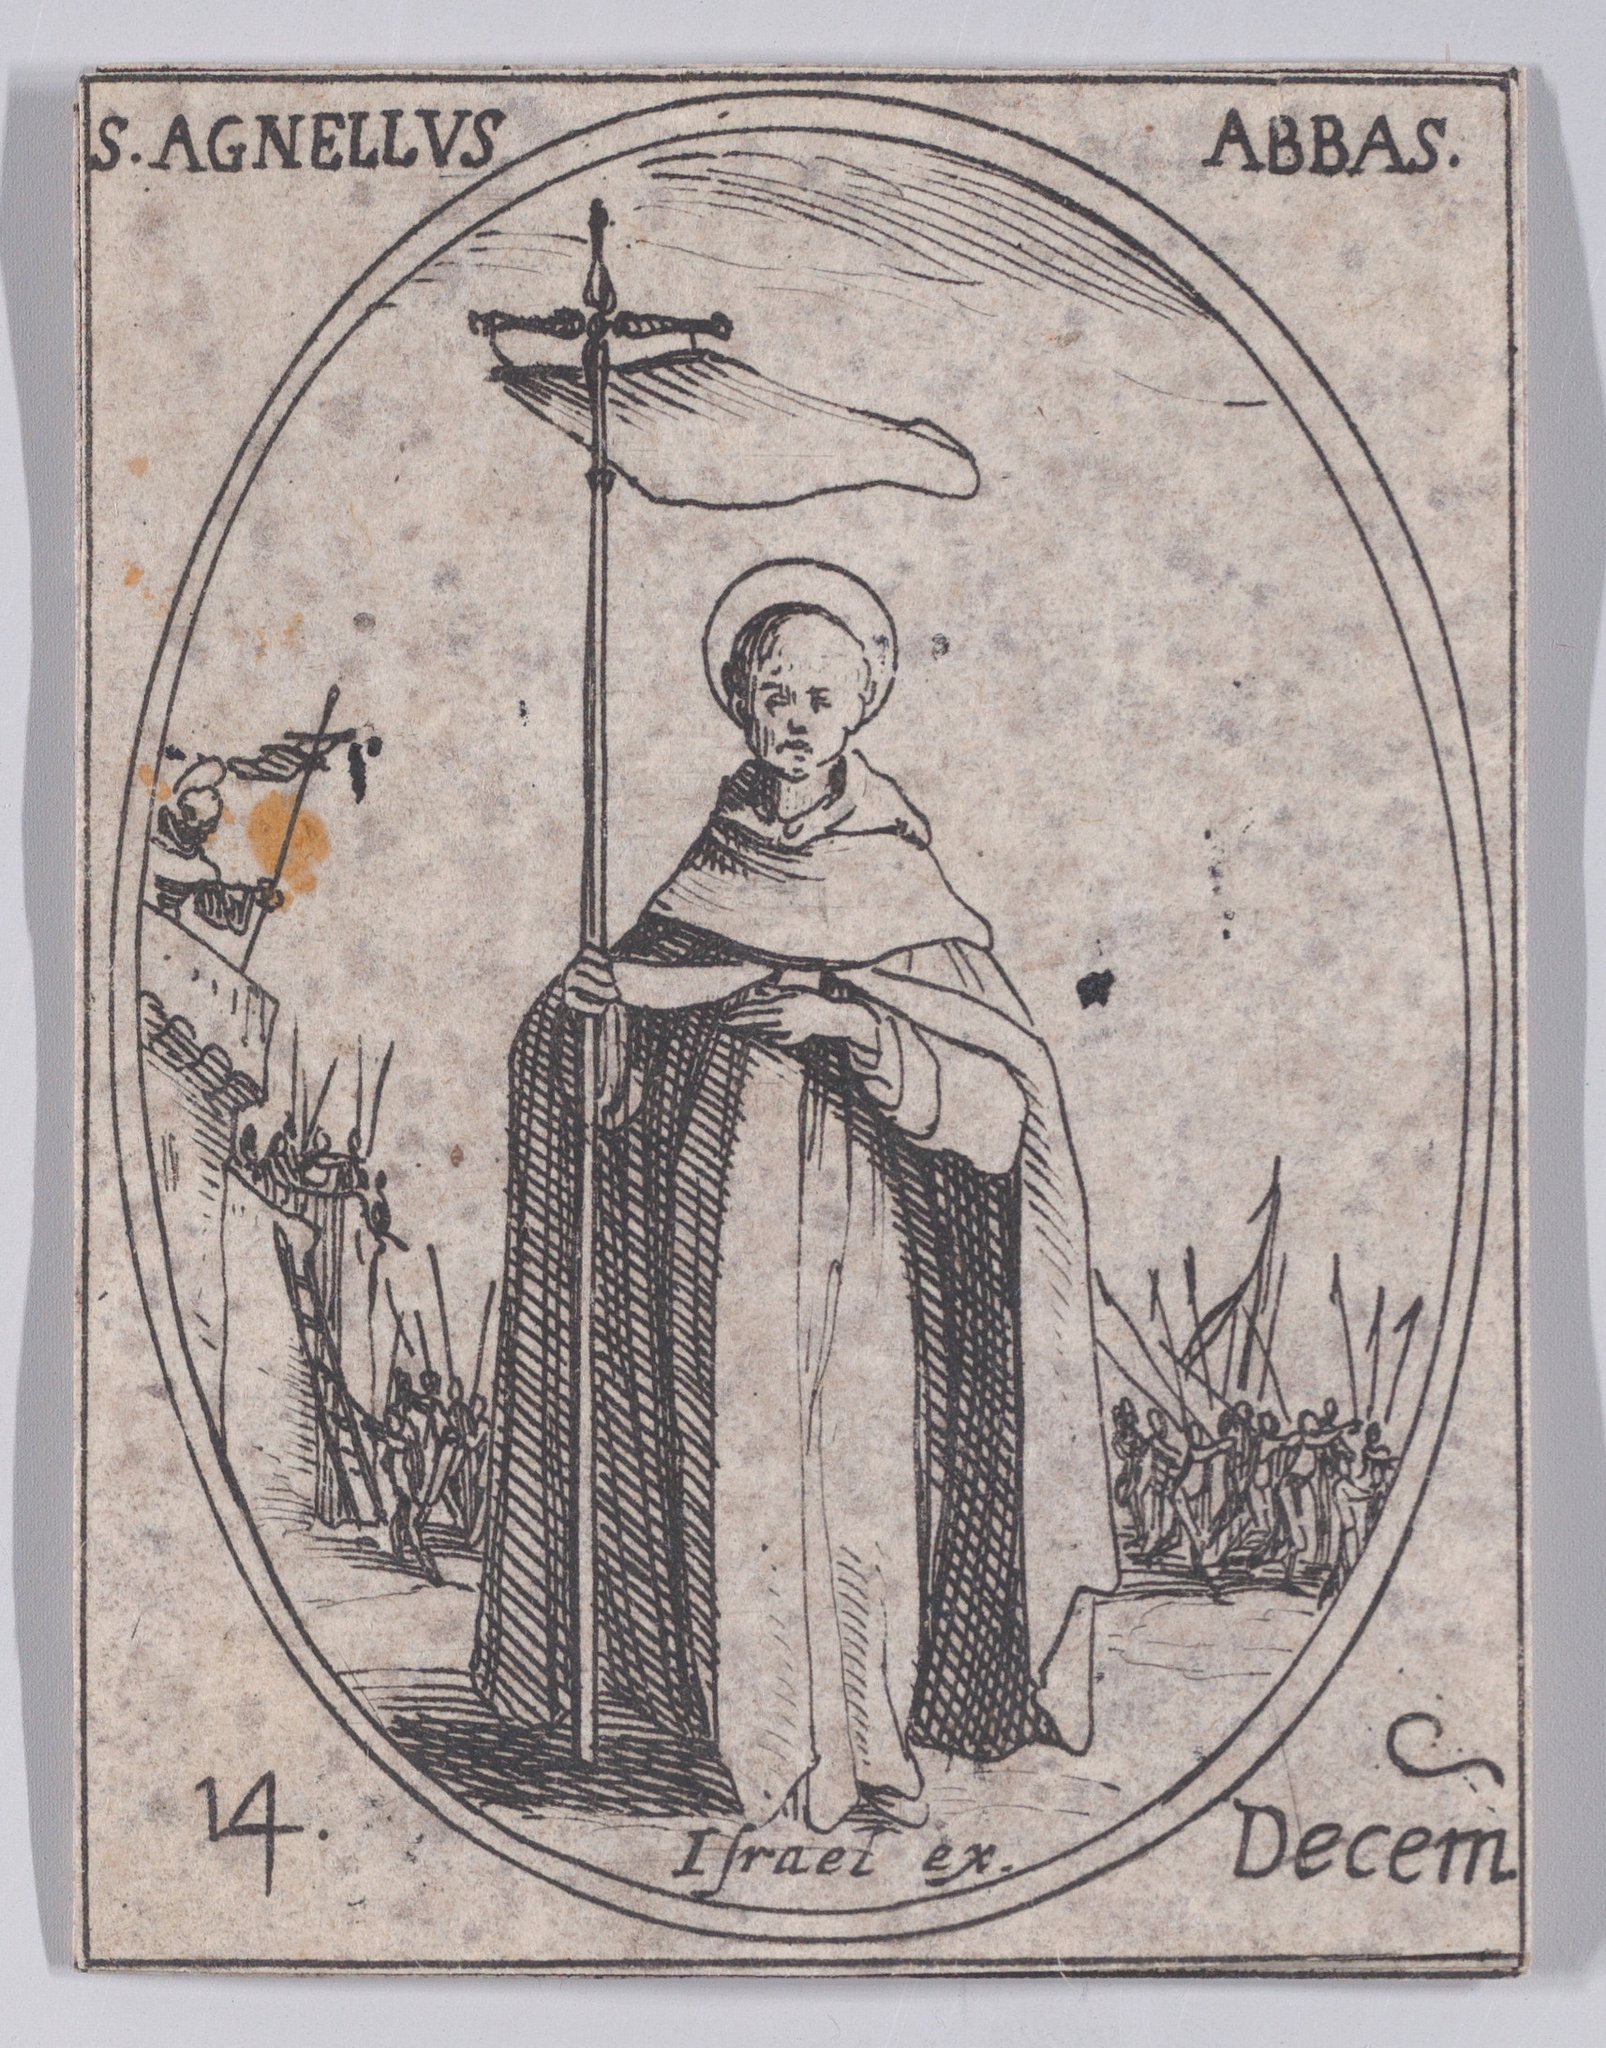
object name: print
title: S. Agnelet, abbé (St. Agnellus, Abbot), December 14th, from "Les Images De Tous Les Saincts et Saintes de L'Année" (Images of All of the Saints and Religious Events of the Year)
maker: jacques callot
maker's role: artist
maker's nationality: french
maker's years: 1592-1635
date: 1636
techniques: etching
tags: men,saints